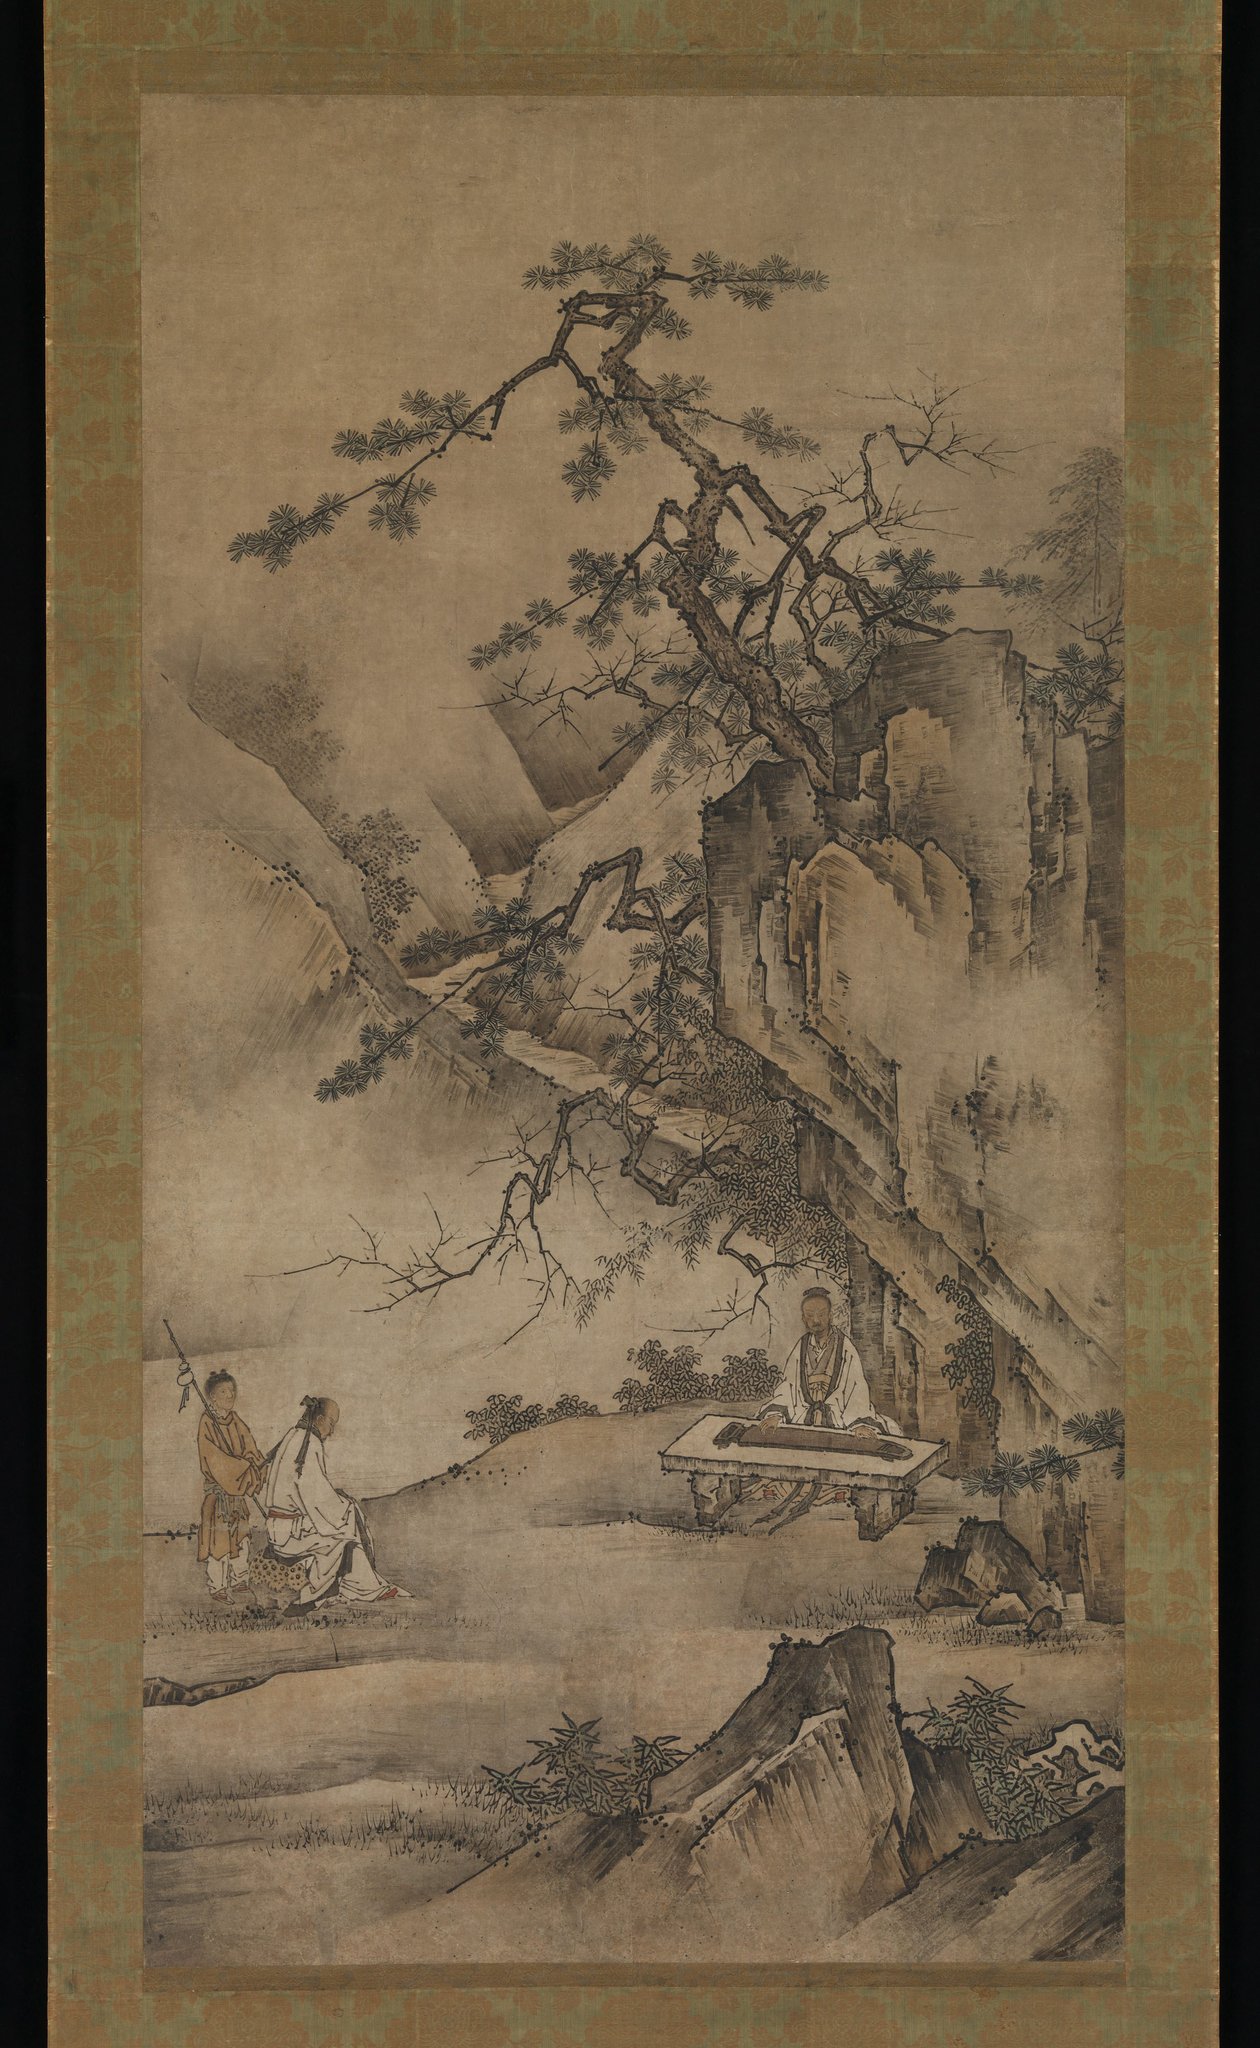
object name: hanging scroll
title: Bo Ya Plays the Qin as Zhong Ziqi Listens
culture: japanese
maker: kano motonobu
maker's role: artist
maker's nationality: japanese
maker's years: 1477-1559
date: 1530-1539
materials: ink, paper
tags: musical instruments,men,landscapes